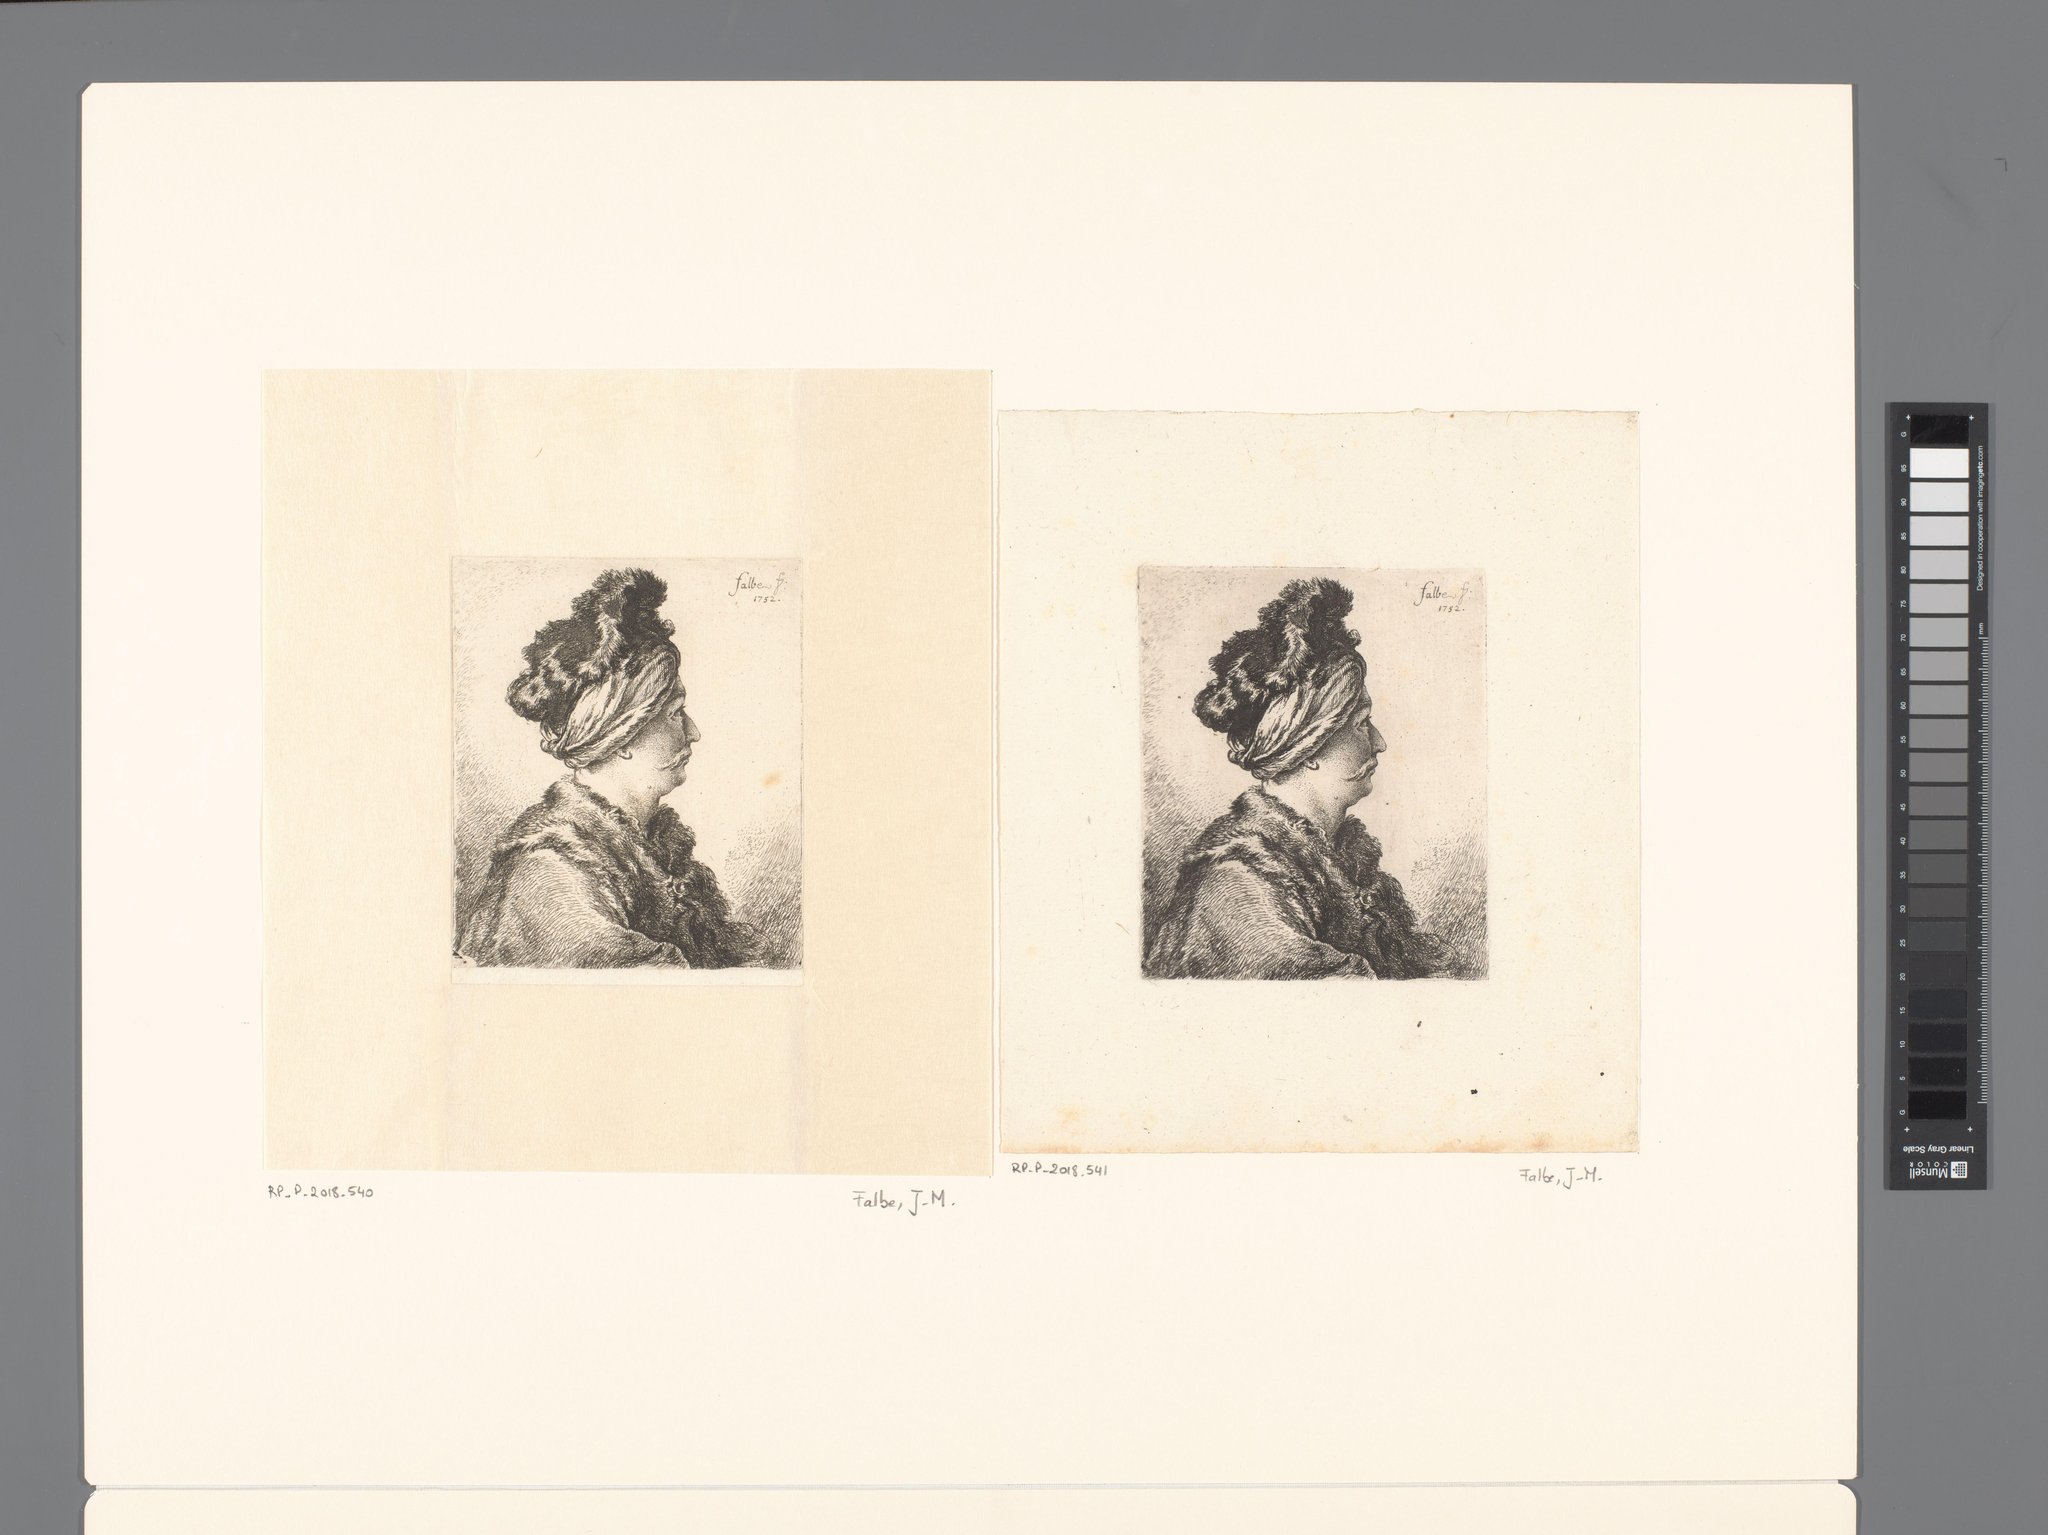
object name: print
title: Buste ten halve lijve van een jongeman met bontmuts en jas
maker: joachim martin falbe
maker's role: print maker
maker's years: 1709-1782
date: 1752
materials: paper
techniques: etching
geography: berlin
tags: head-gear (with name), head-gear: hat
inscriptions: collector's mark: Lugt 2760, collector's mark: Lugt 2228